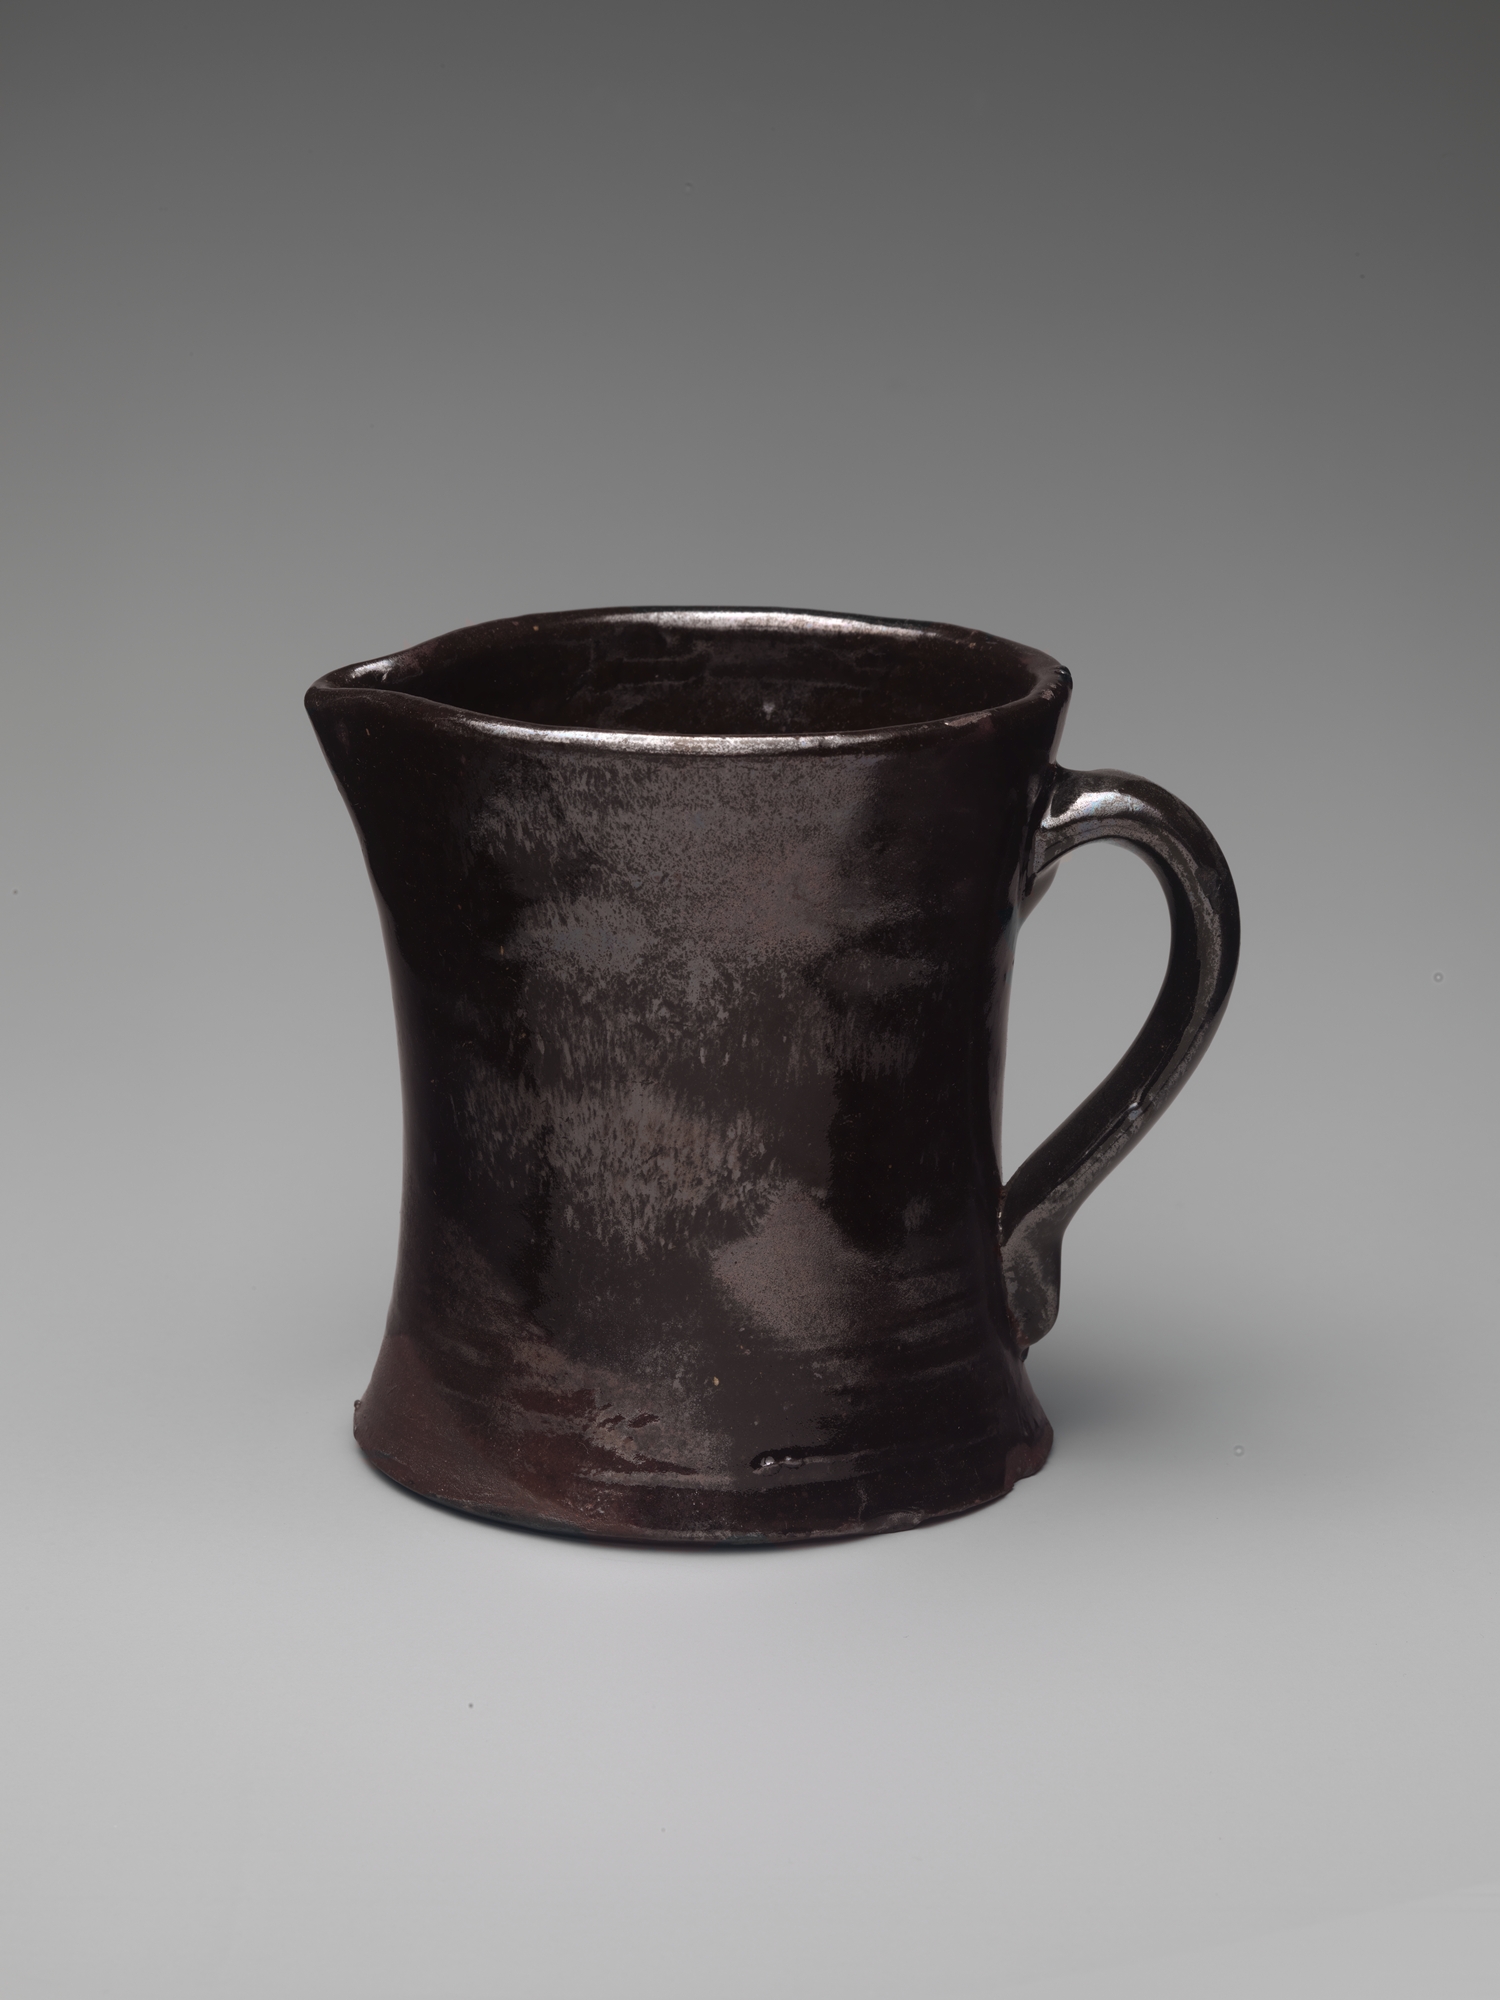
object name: mug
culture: american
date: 1800-1830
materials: earthenware